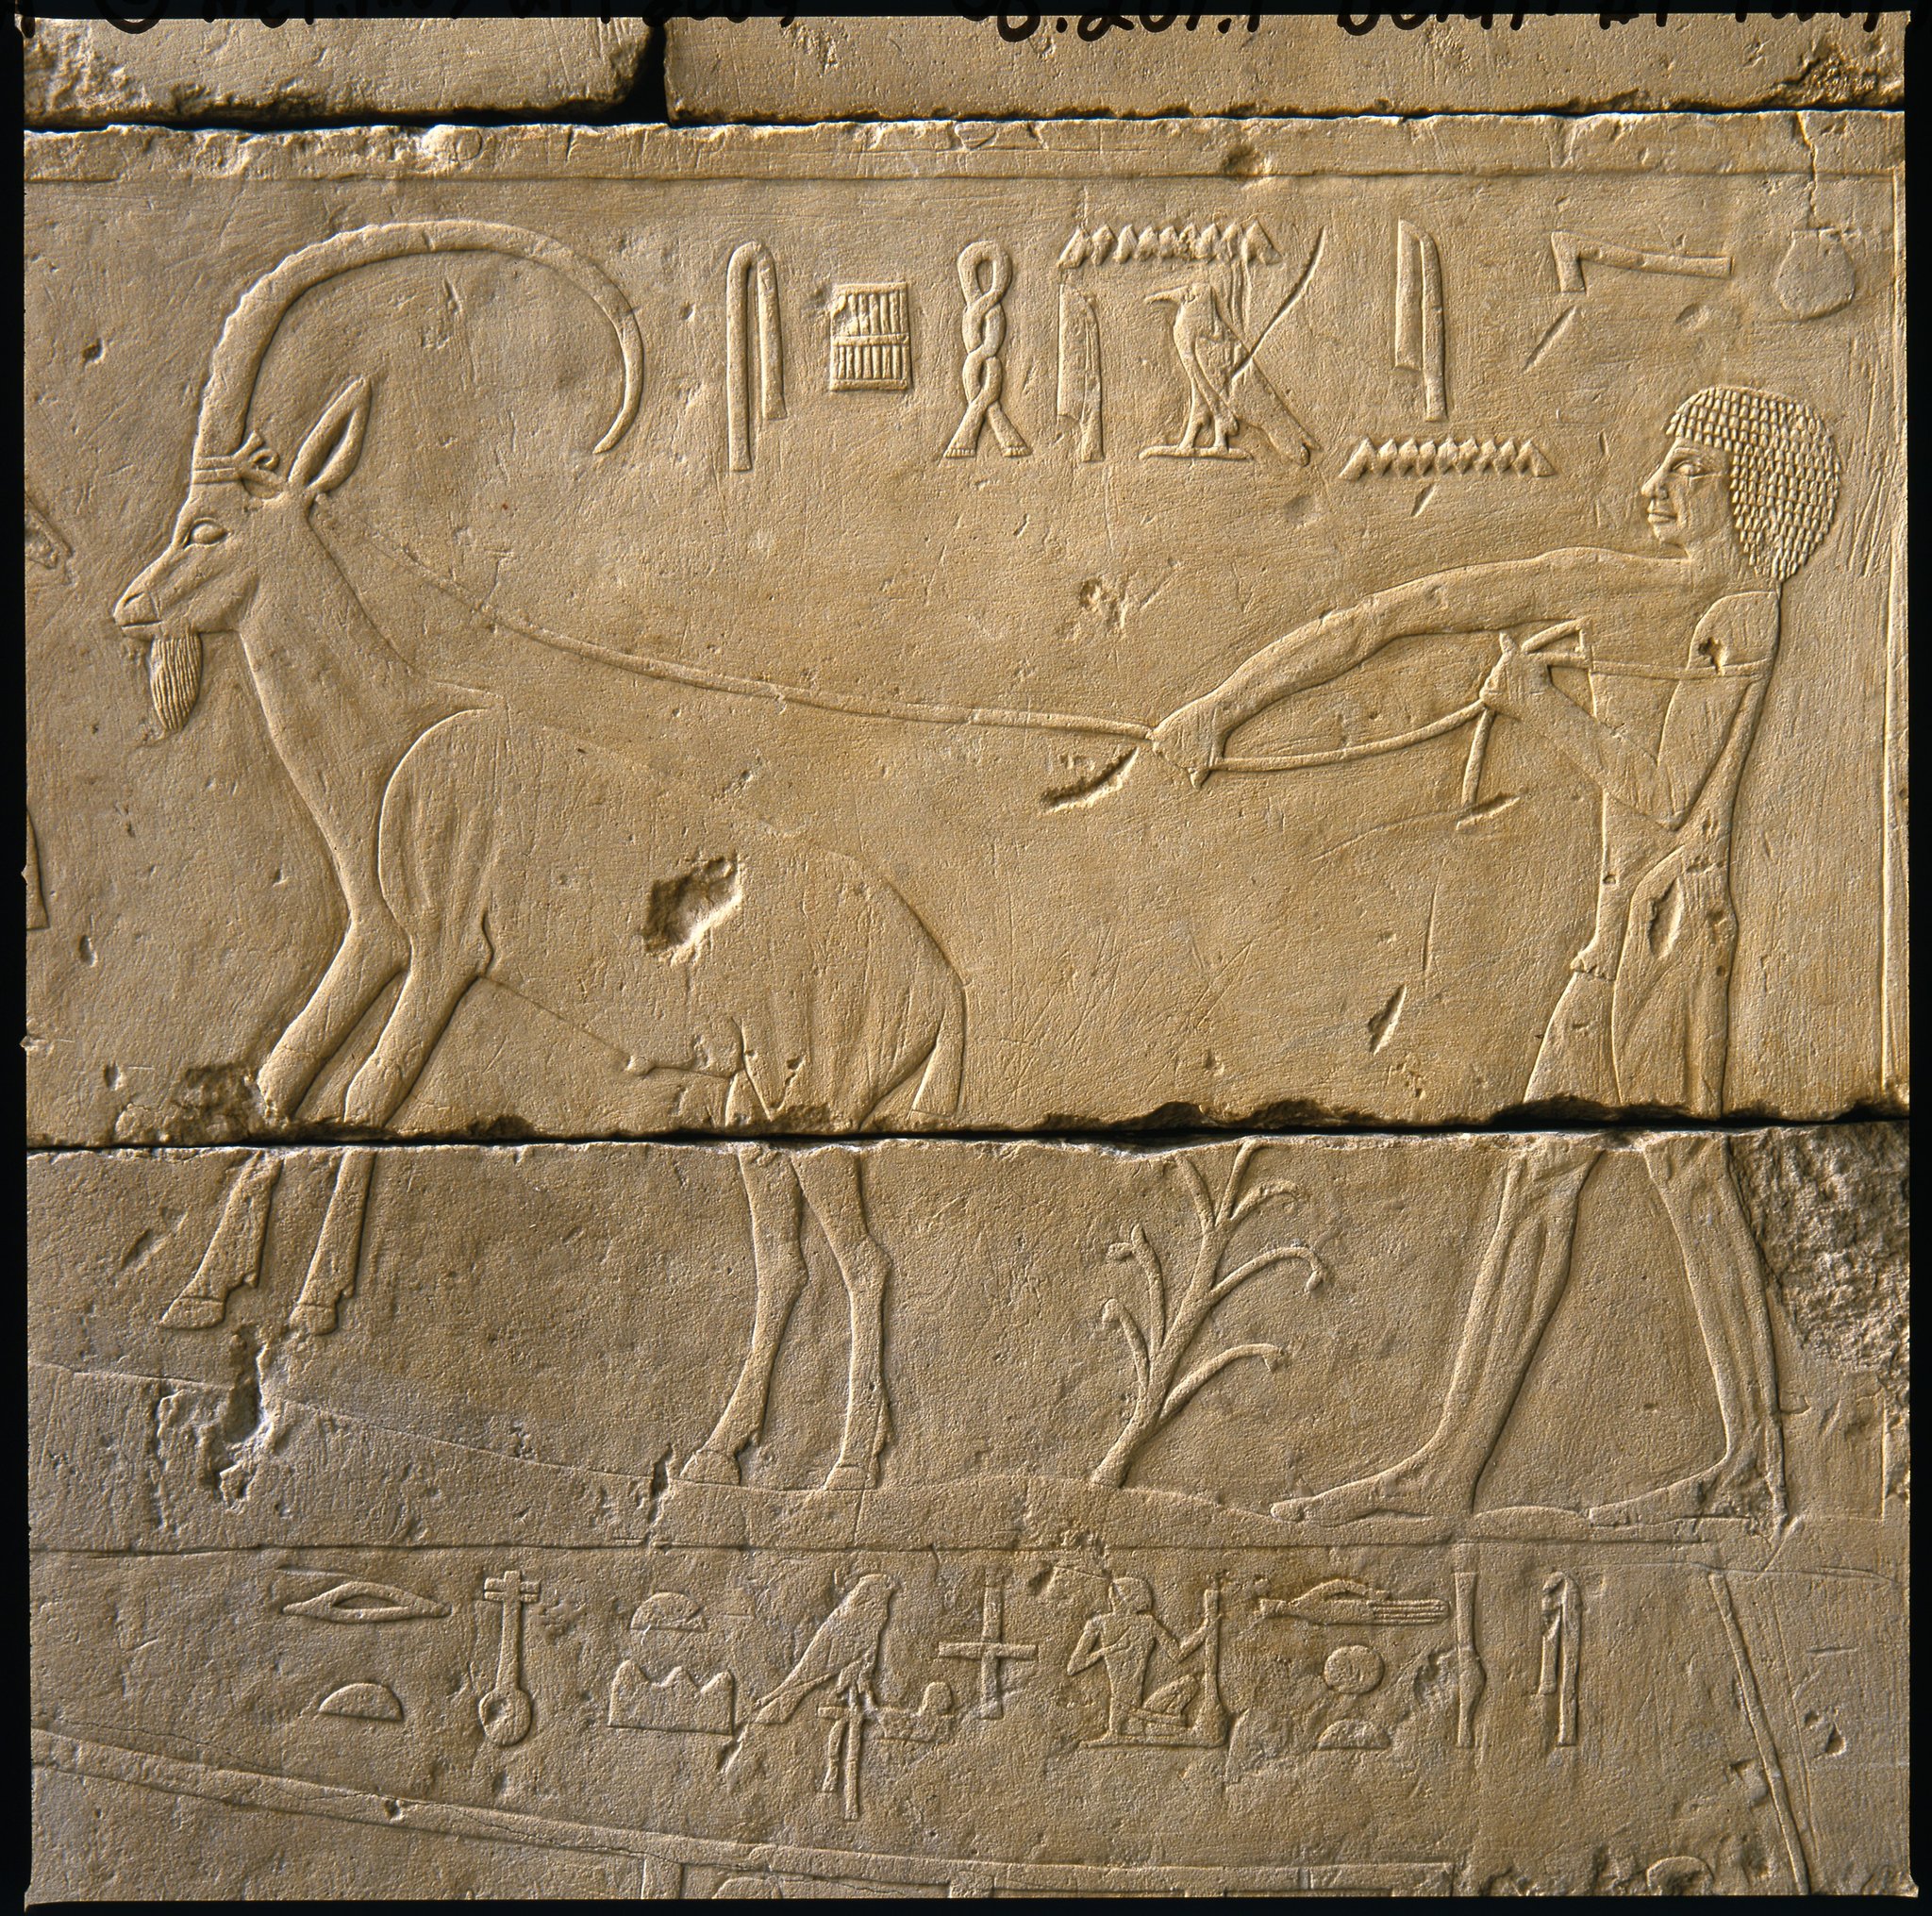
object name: relief, tomb chapel, raemkai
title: Tomb Chapel of Raemkai: South Wall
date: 2446-2389 BCE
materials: limestone, paint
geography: egypt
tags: animals,men,hieroglyphs